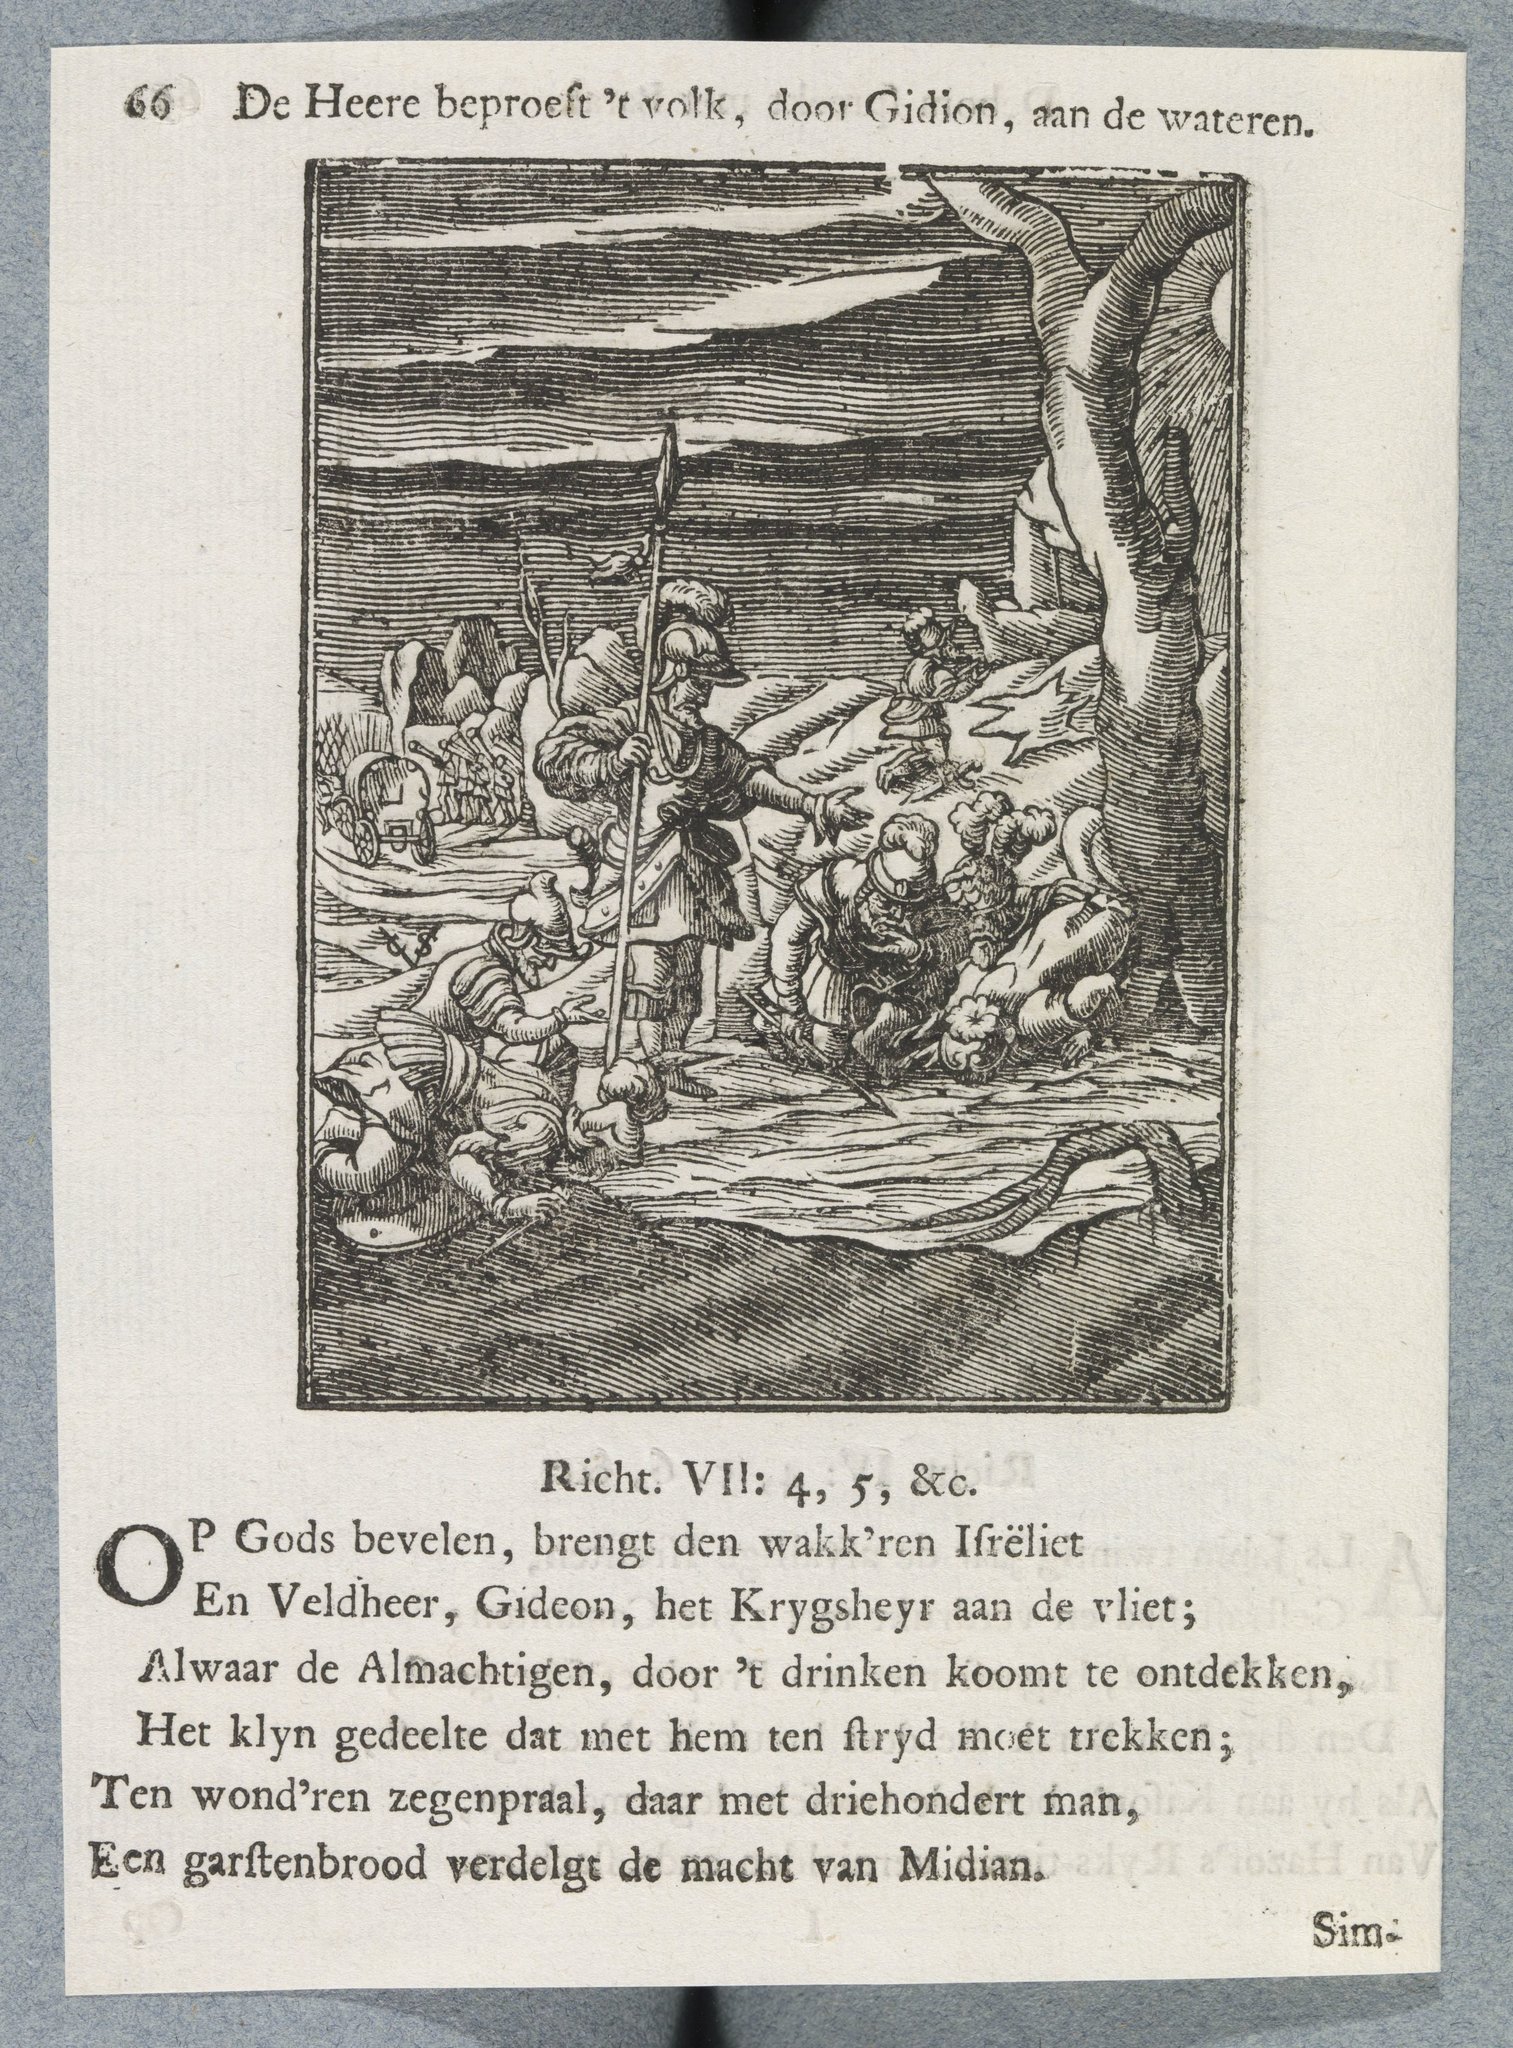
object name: print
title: De Heere beproeft 't volk, door Gidion, aan de wateren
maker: jan klooster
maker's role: bookseller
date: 1645-1646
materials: paper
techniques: letterpress printing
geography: amsterdam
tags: those who lap water by putting their hand to their mouth are separated from those who kneel down to drink the water ~ selection of gideon's men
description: Gideon heeft zijn mannen naar het water gebracht en laat hen drinken. Degenen die het water met hun tong oplikken neemt hij mee in de strijd. De mannen die knielen om het water te drinken worden naar huis gestuurd. Boven de voorstelling een titel. Eronder zes versregels en een verwijzing naar Richteren 7: 4-5. De prent maakt deel uit van een album.